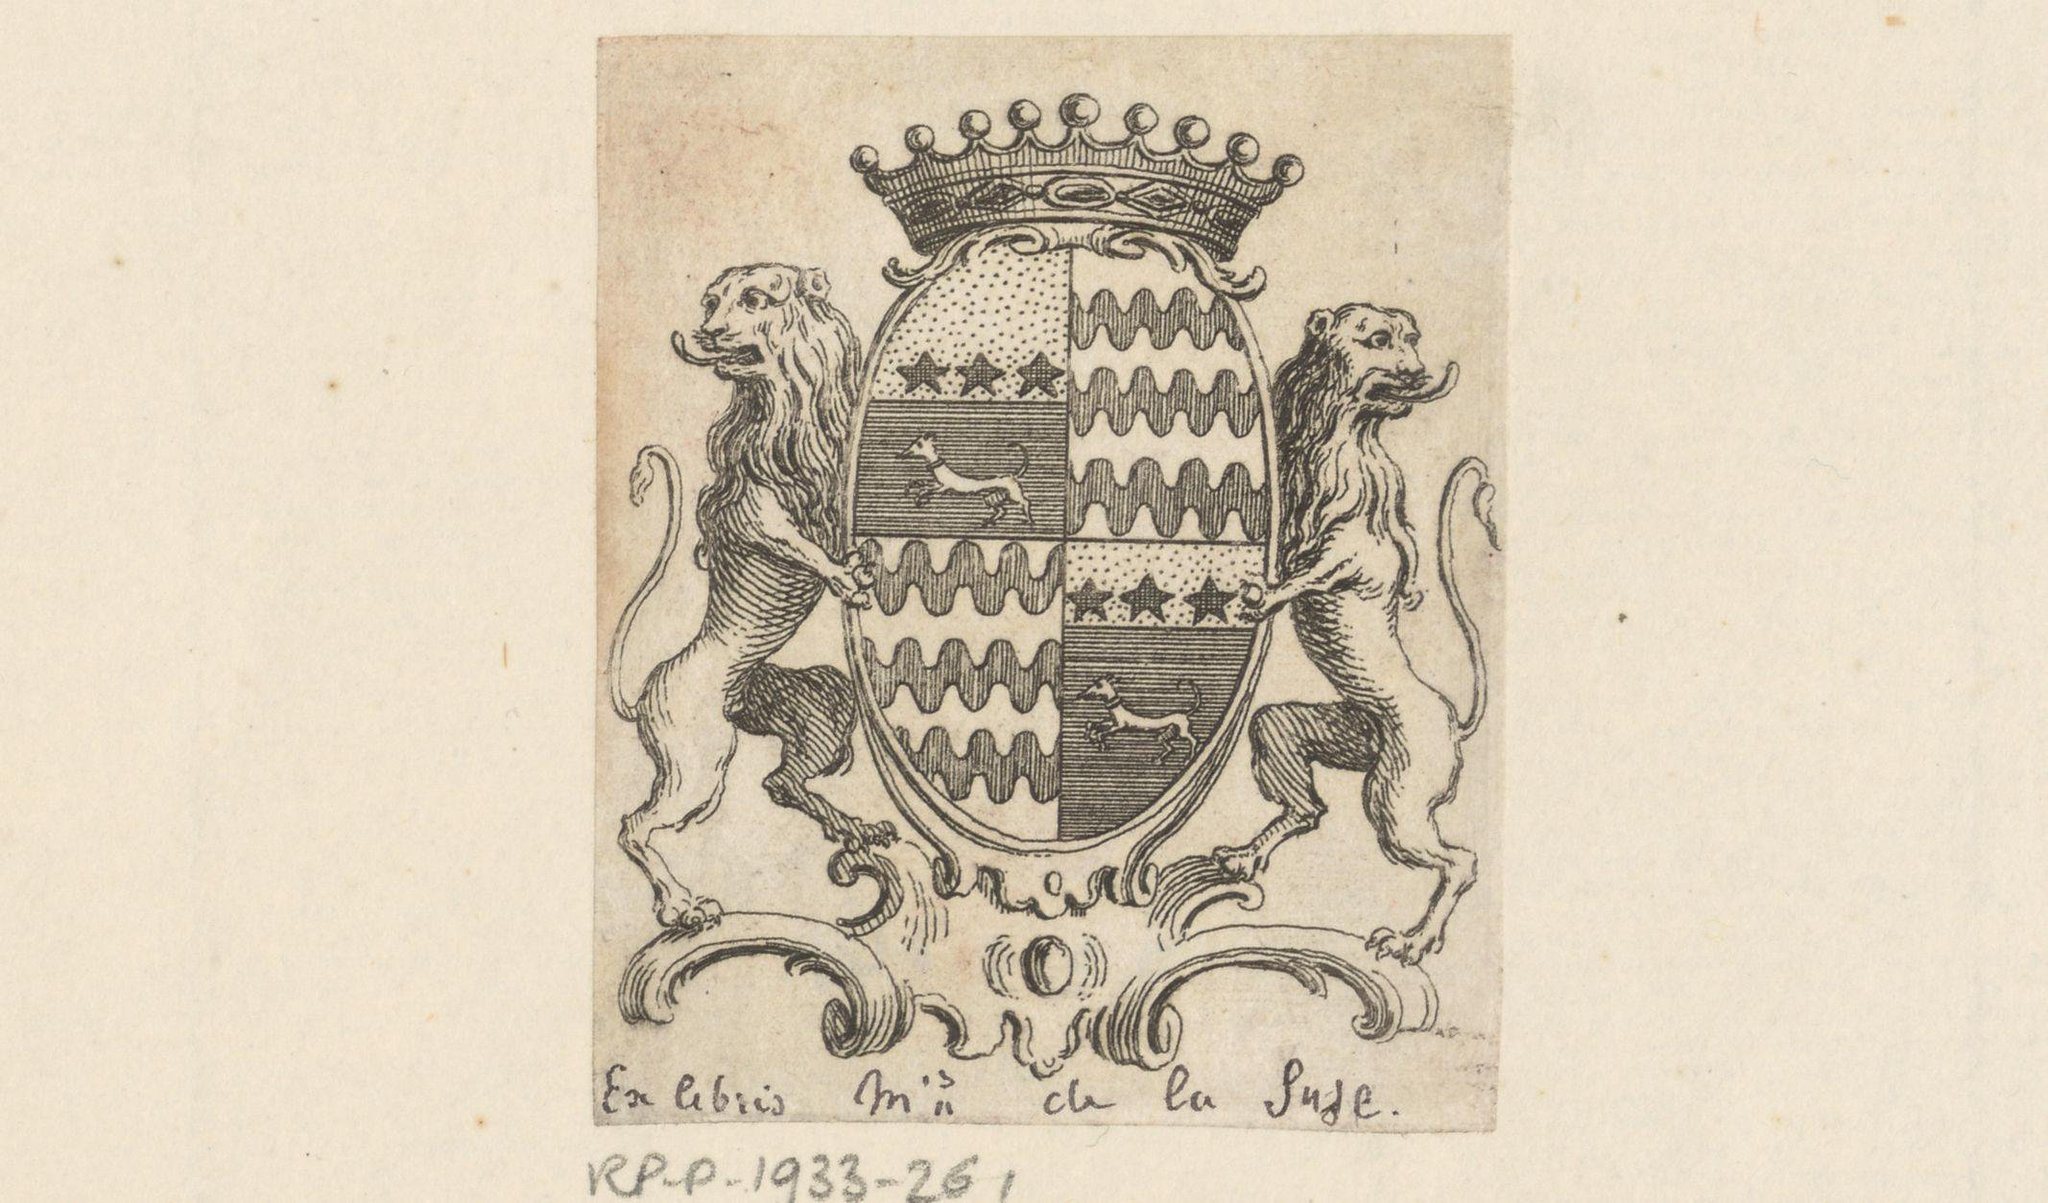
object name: bookplate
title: Ex libris Msr. de la Suse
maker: Anonymous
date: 1600-1749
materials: paper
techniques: etching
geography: france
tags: beasts of prey, predatory animals: lion, armorial bearing, heraldry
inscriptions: collector's mark: Lugt 2760